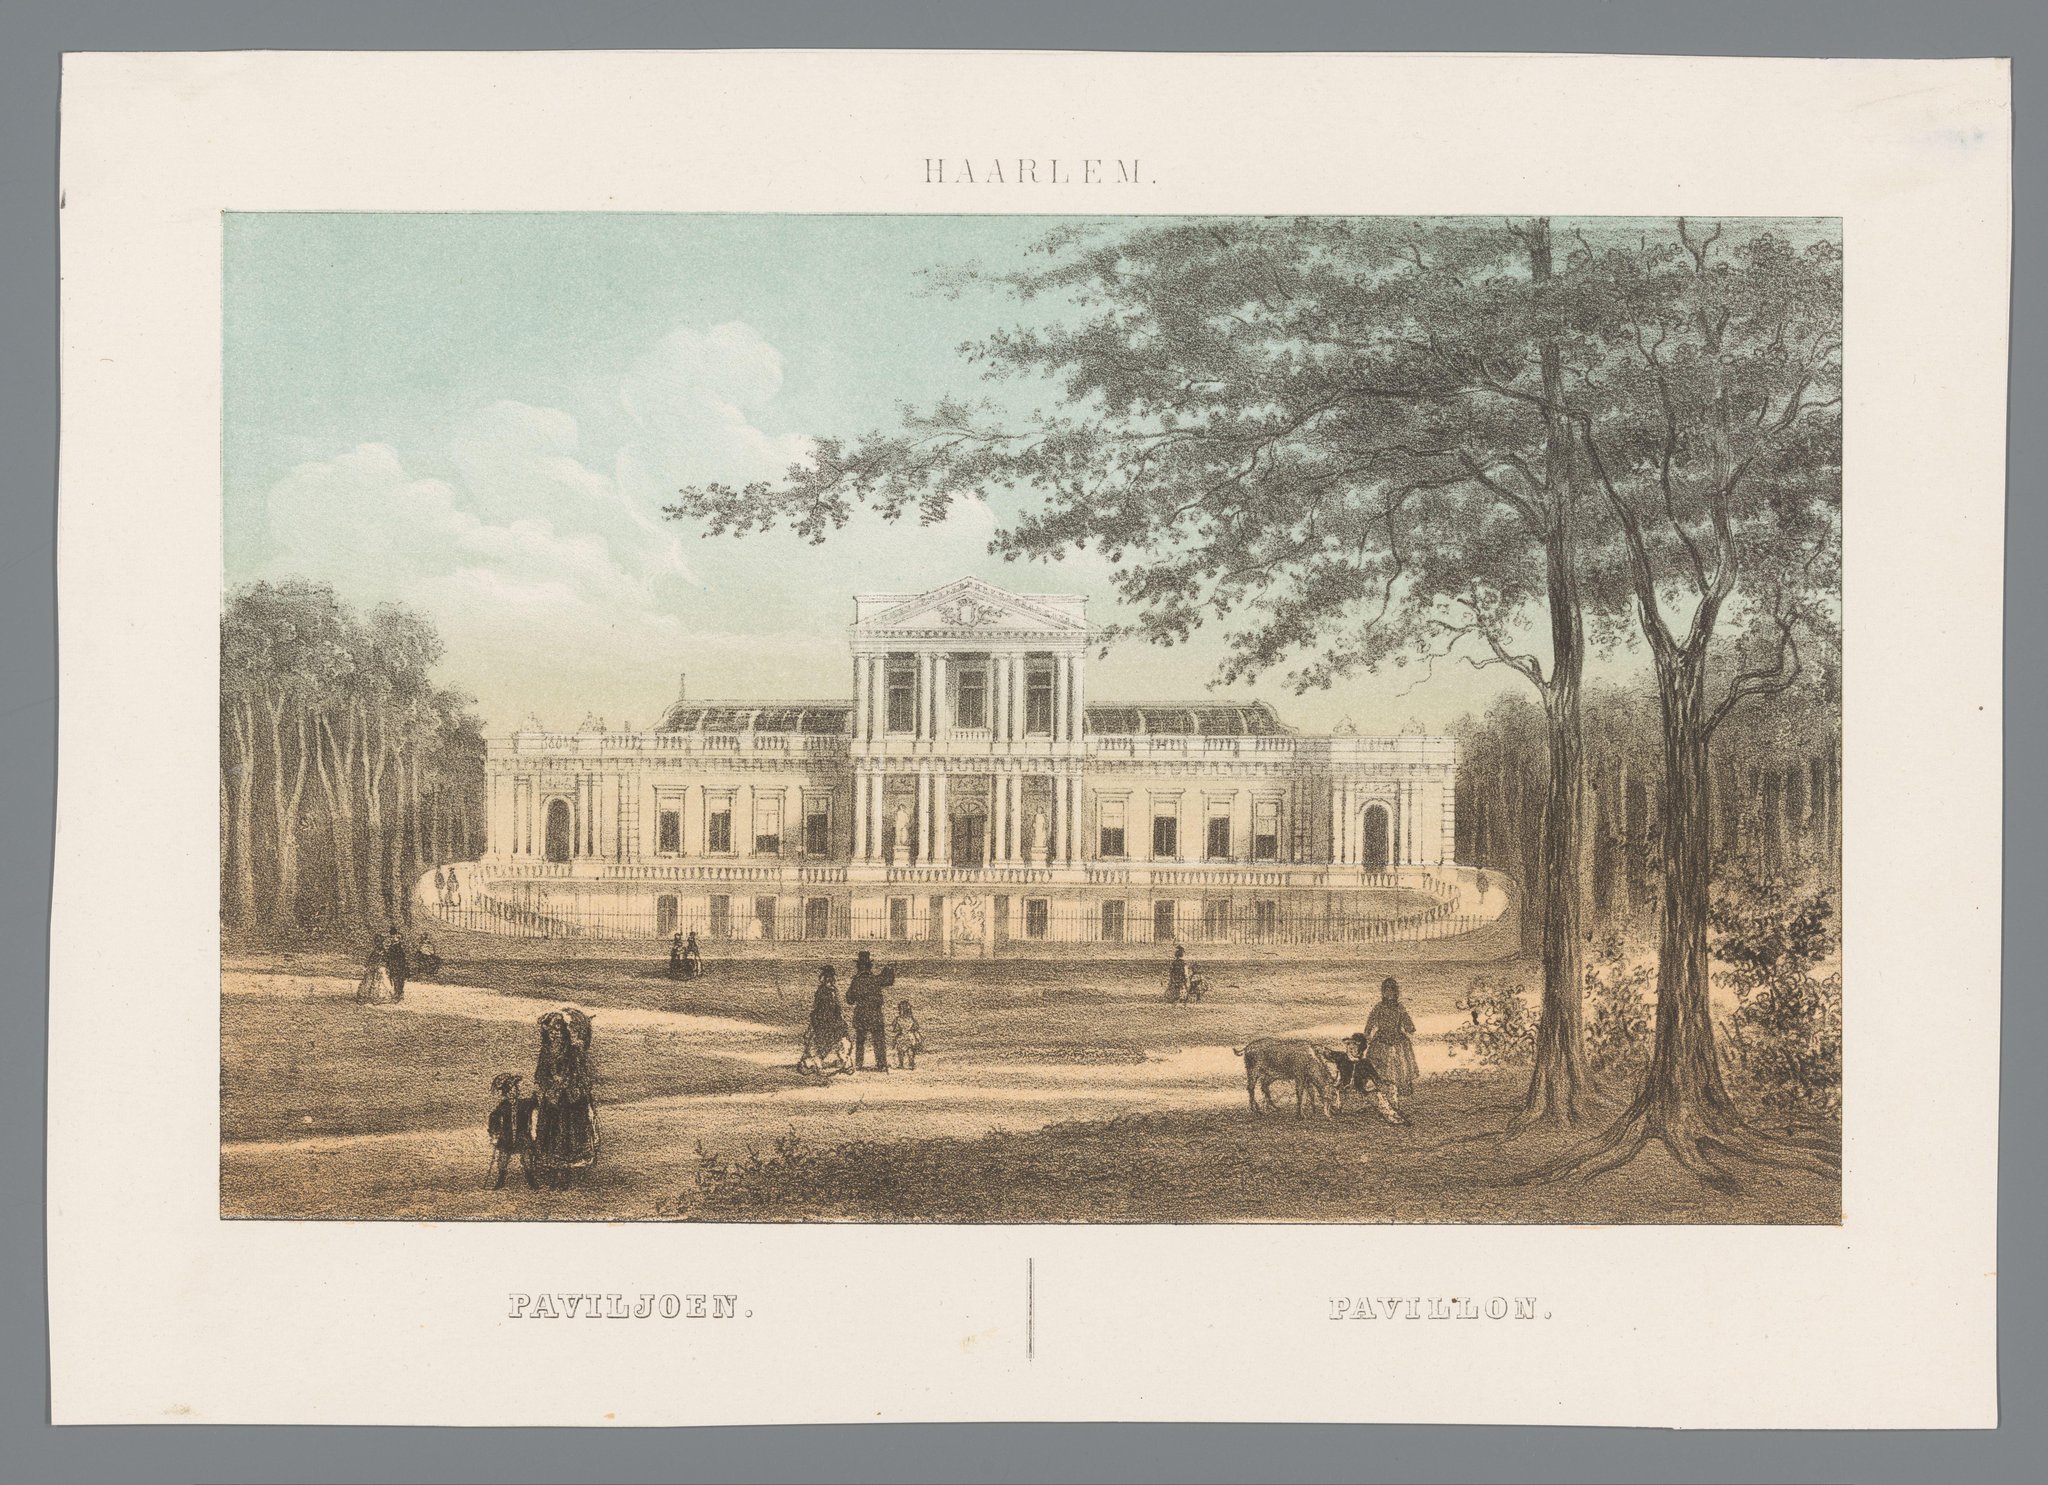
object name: print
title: Haarlem: Paviljoen / Pavillon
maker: Anonymous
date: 1850-1900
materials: paper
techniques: tone lithography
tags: edifice, e.g.: public building, department store